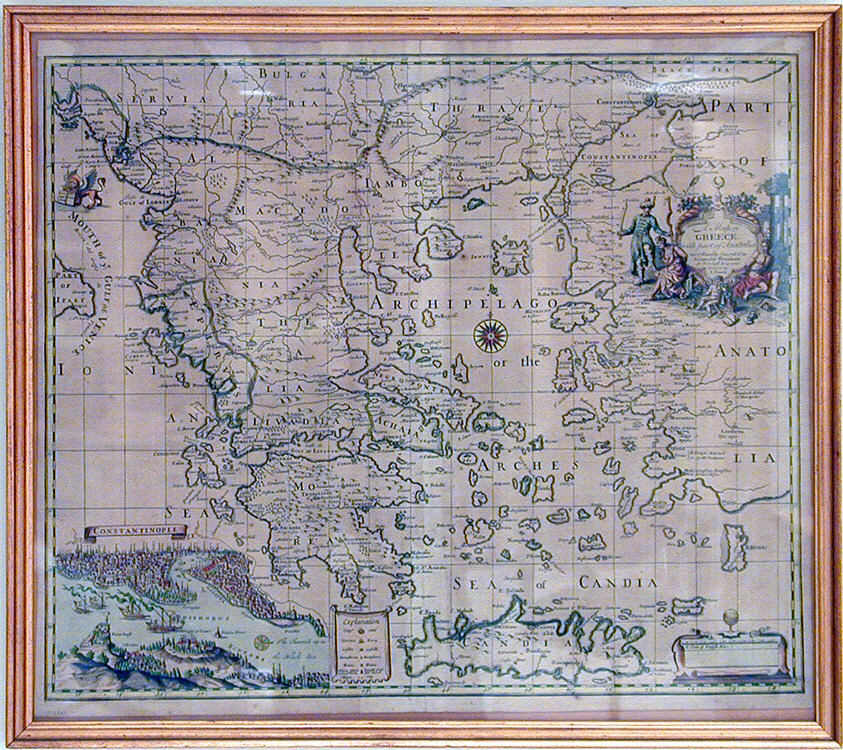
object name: map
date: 1701-1800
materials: ink, paper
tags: ruins,maps